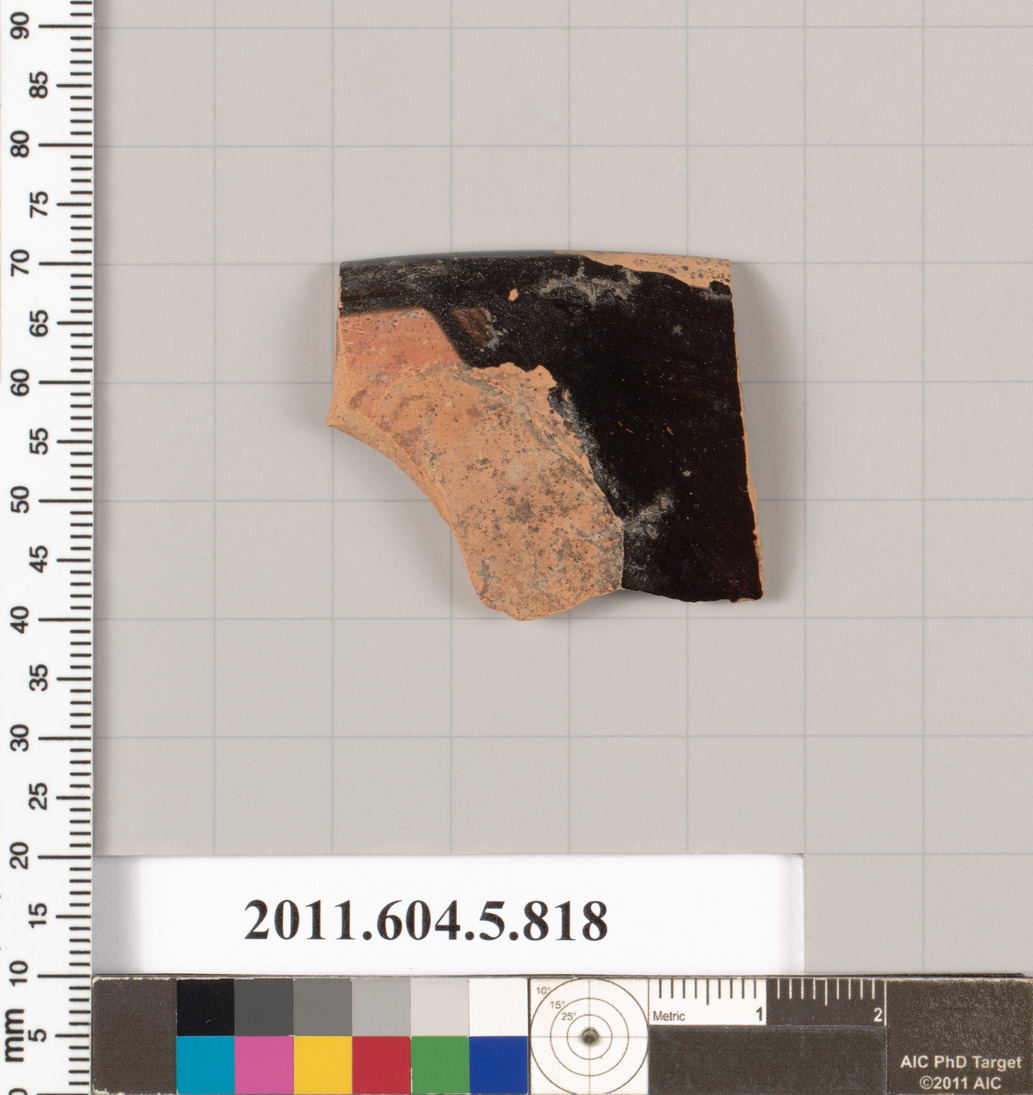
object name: kylix fragment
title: Terracotta rim fragment of a kylix (drinking cup)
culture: greek, attic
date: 600-401 BCE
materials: terracotta